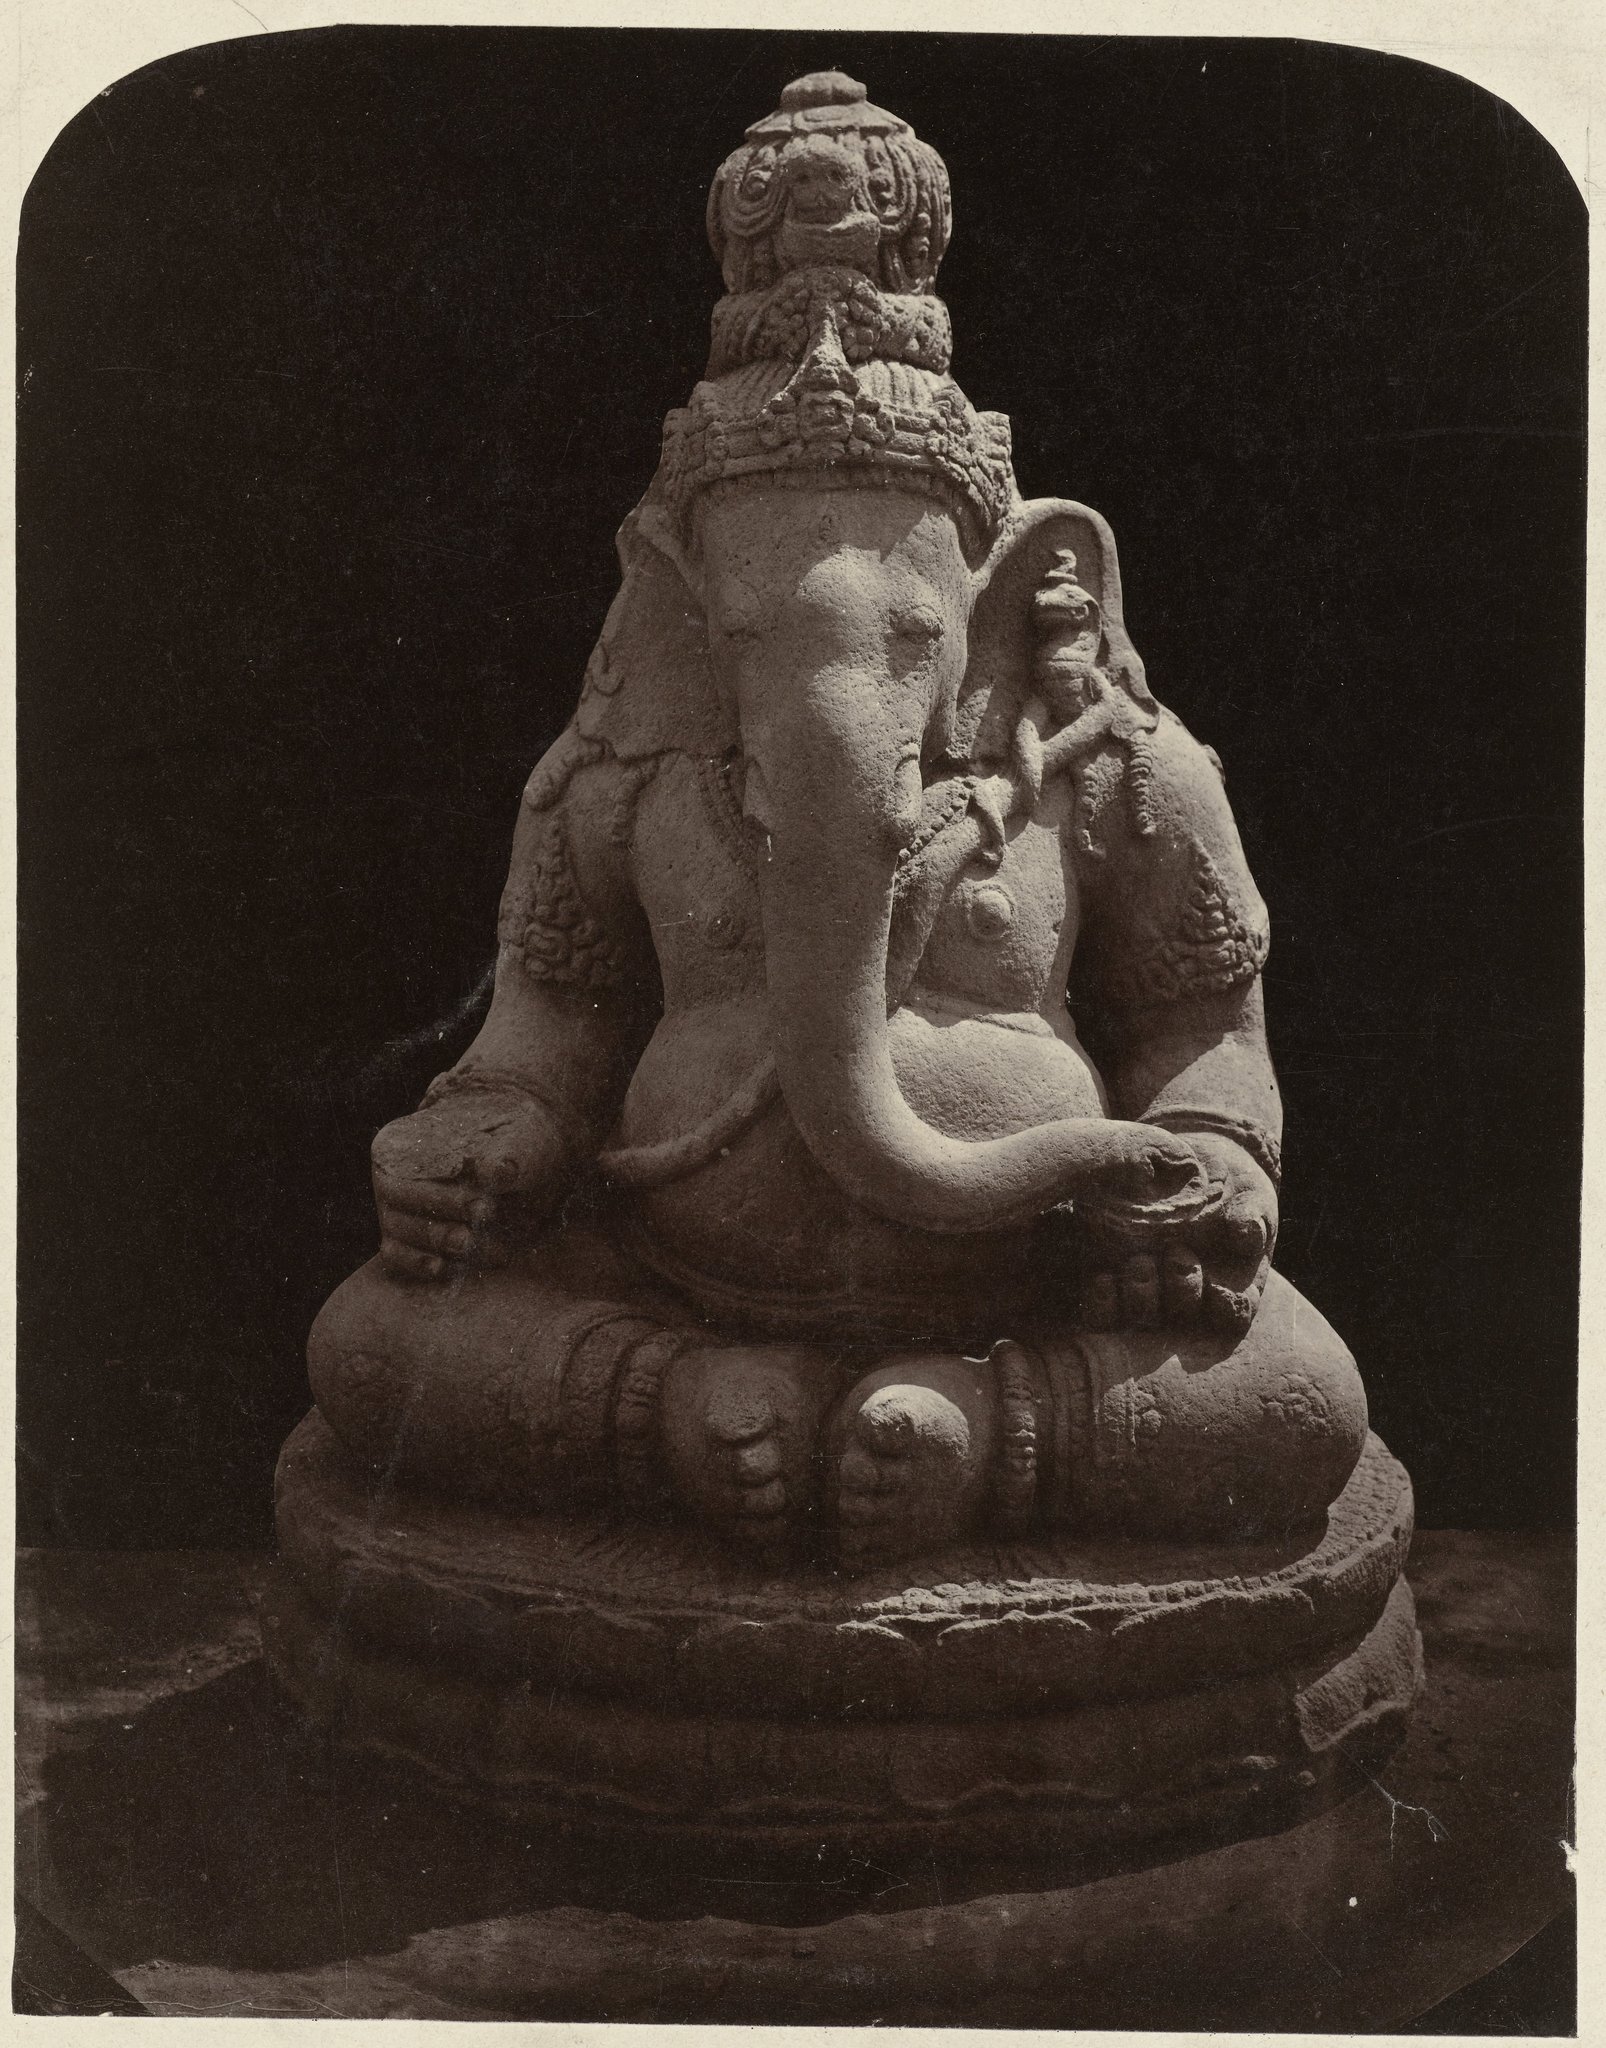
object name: photograph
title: Two armed Ganesha (former Lichte collection). Yogyakarta, Yogyakarta district, D.I. Yogyakarta province, 9th century.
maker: isidore kinsbergen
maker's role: fotograaf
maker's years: 1821-1905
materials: cardboard, paper, photographic support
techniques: albumen print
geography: java